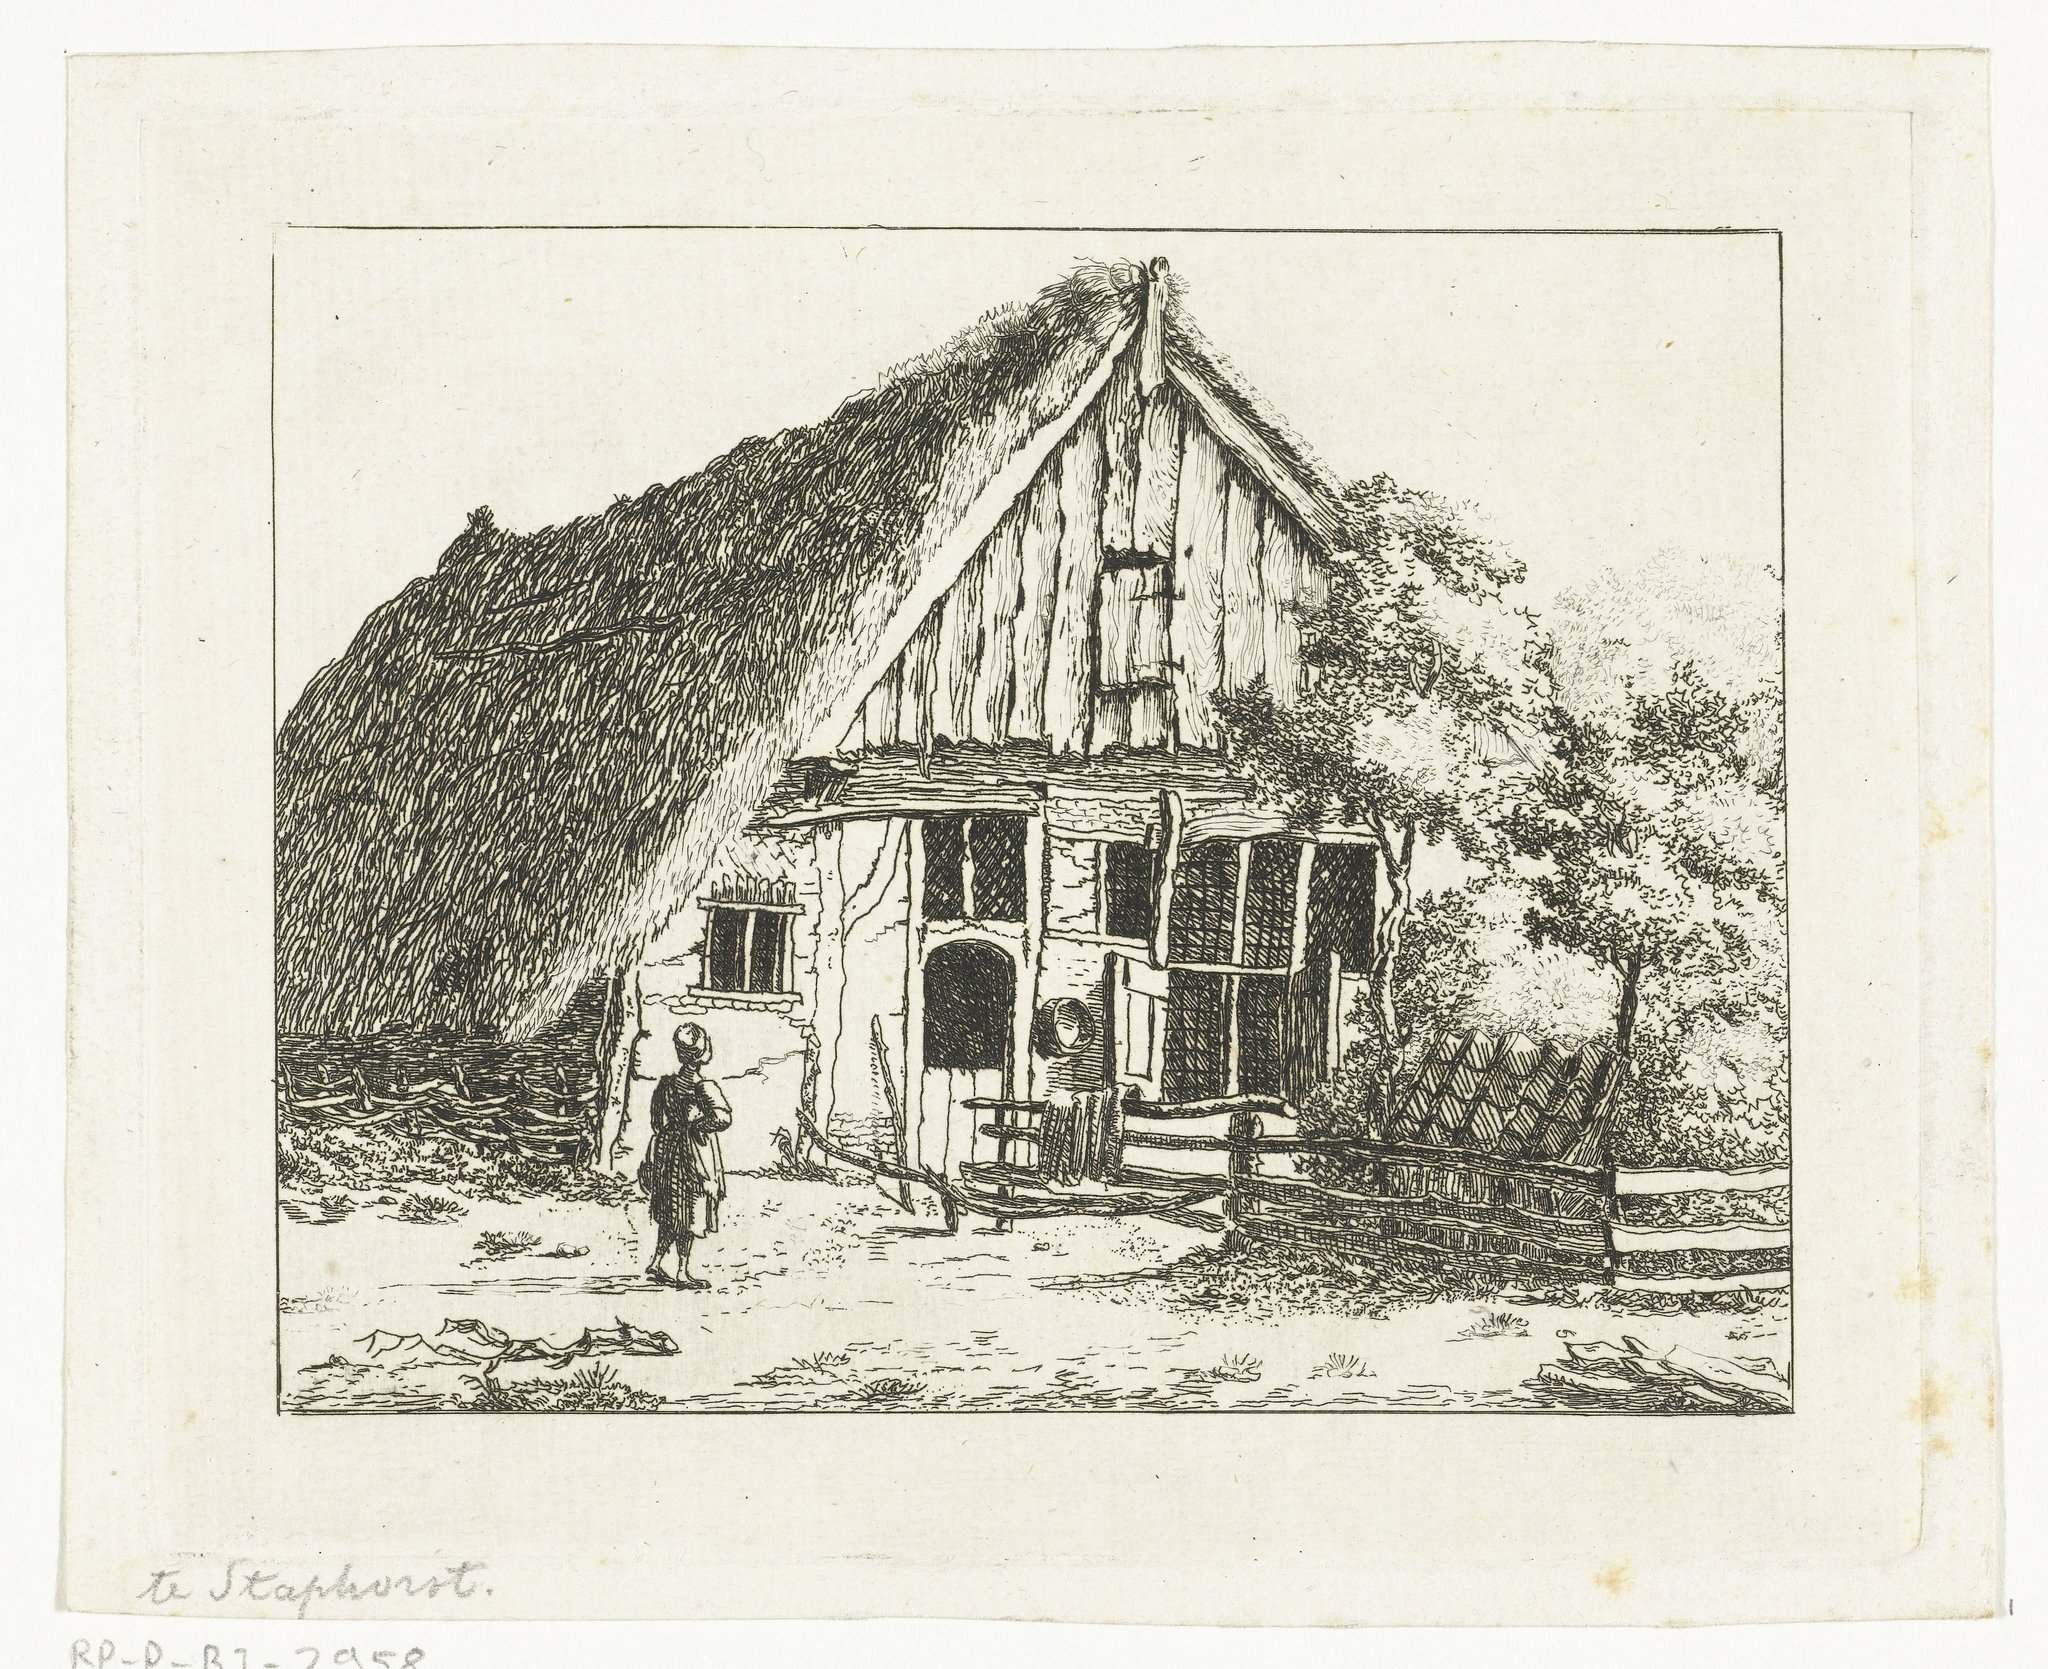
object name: print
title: Vrouw staande voor een huis te Staphorst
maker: anthonie van den bos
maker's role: draughtsman, print maker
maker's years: 1763-1838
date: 1778-1838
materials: paper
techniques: etching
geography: netherlands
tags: farm (building)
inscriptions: collector's mark: Lugt 2228